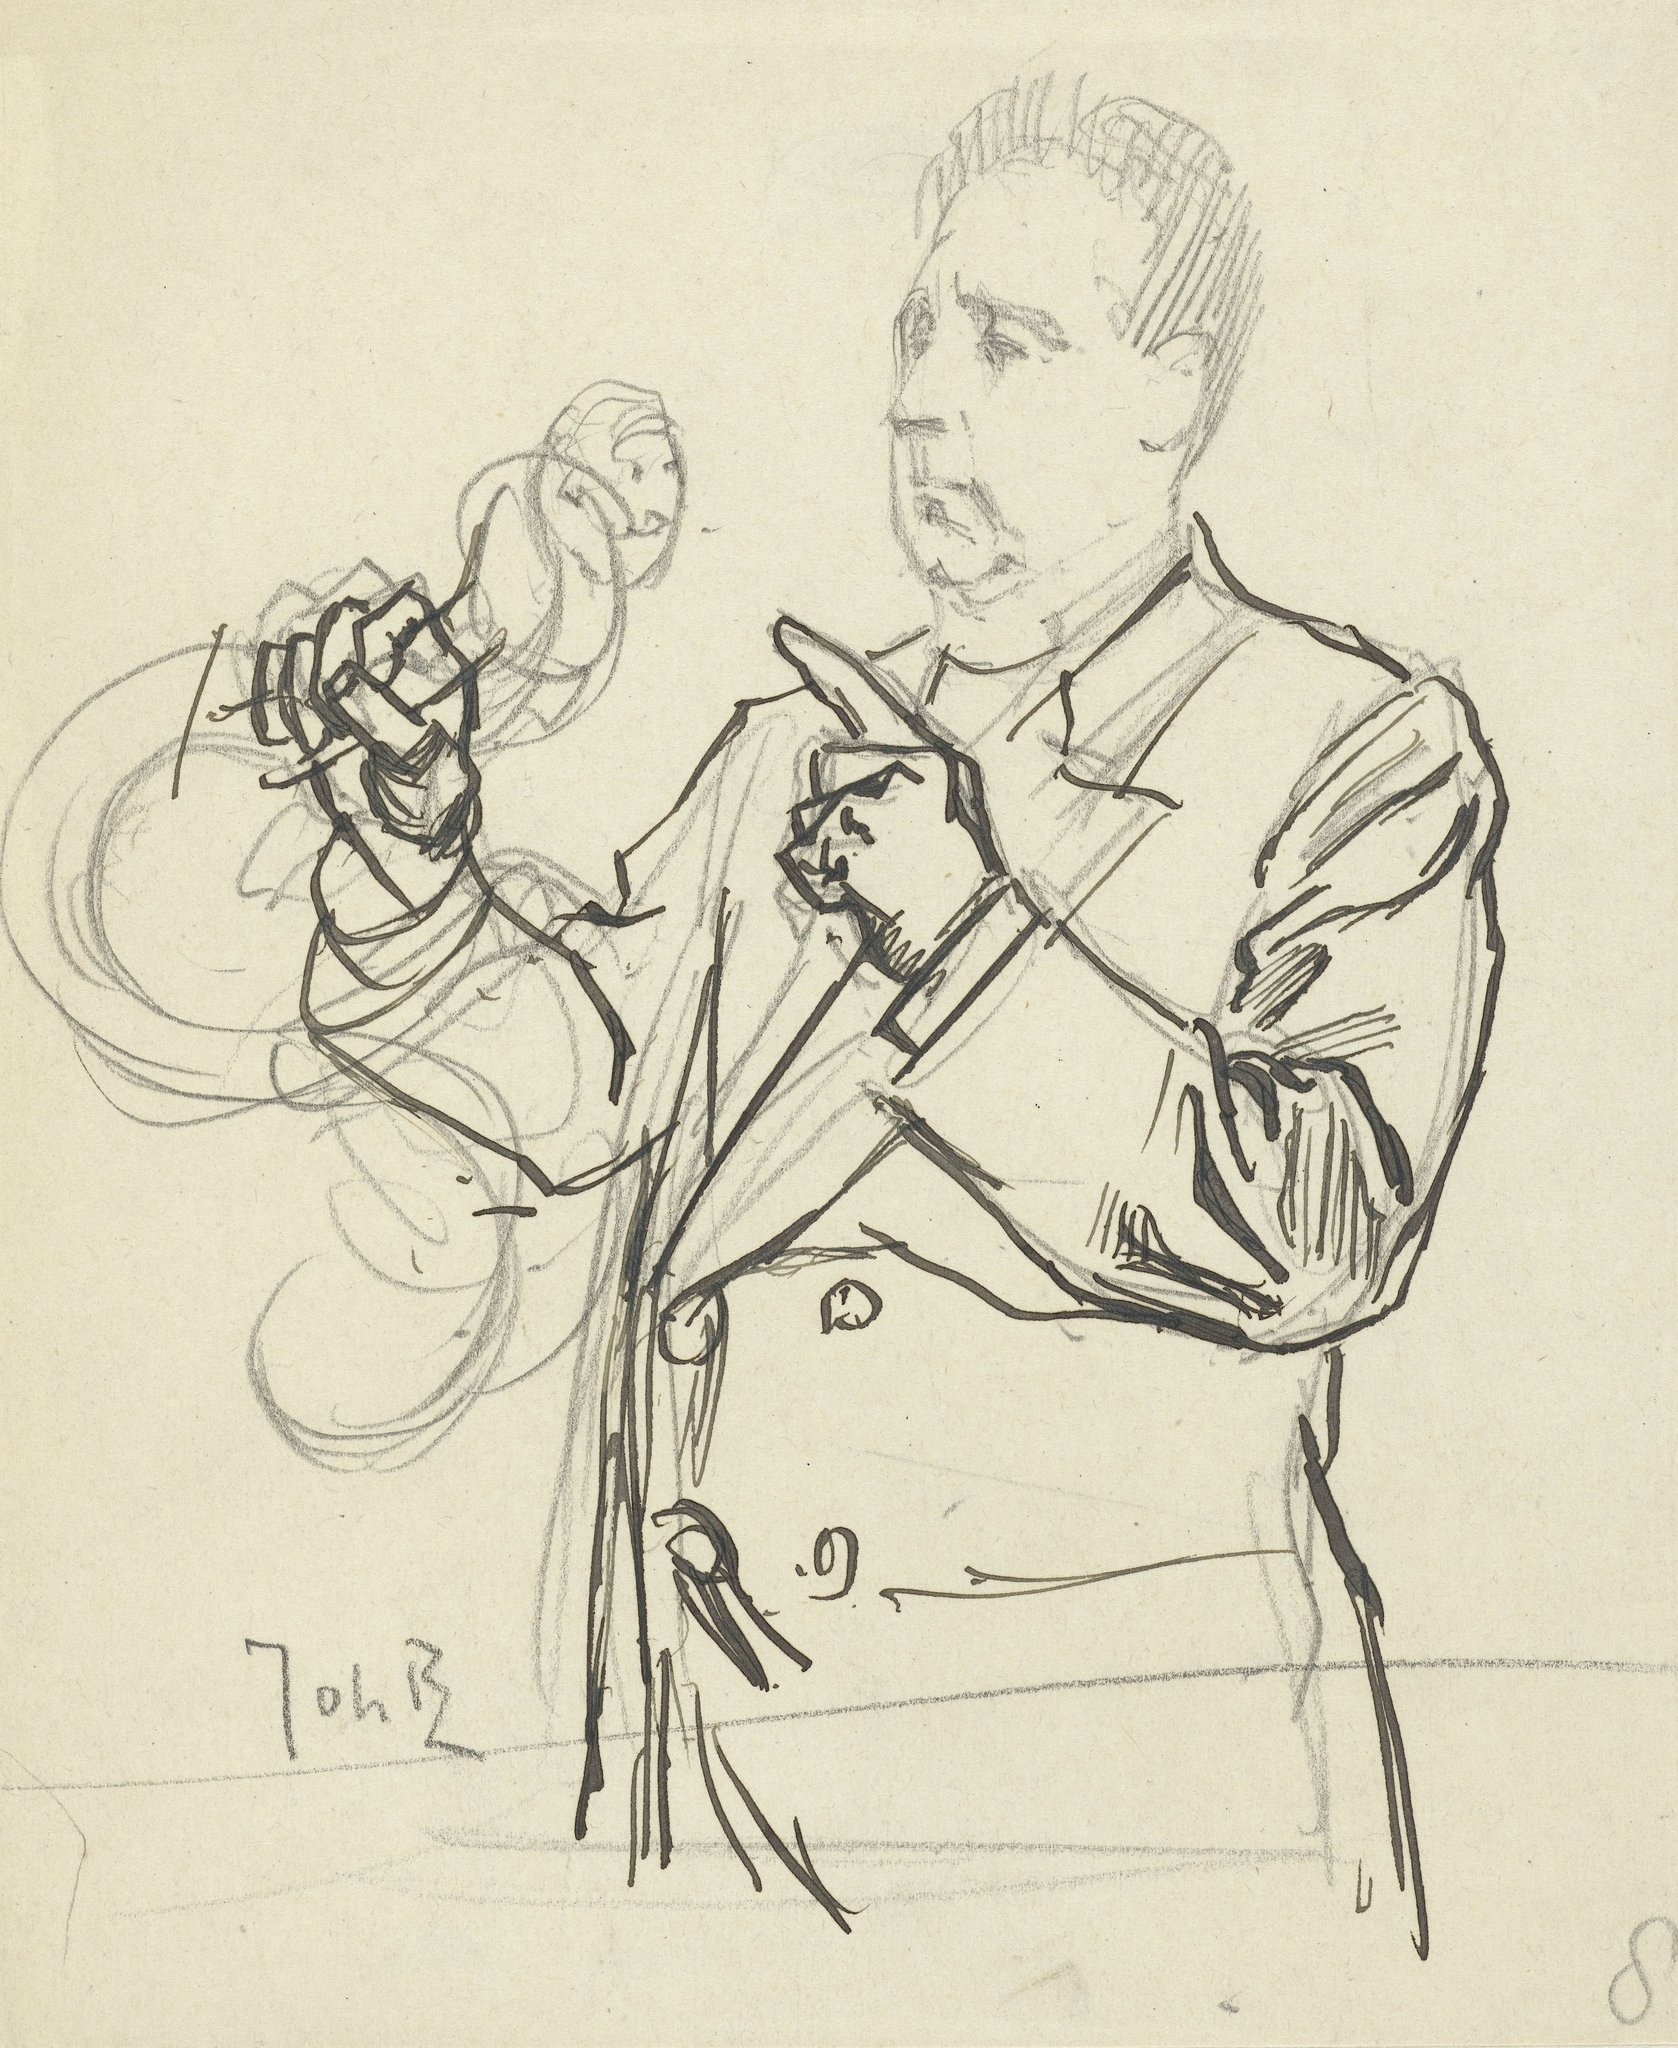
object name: drawing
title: Staande man naar links, met notenkraker (?)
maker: johan braakensiek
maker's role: draughtsman, print maker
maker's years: 1858-1940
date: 1868-1940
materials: ink, paper, pencil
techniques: pen